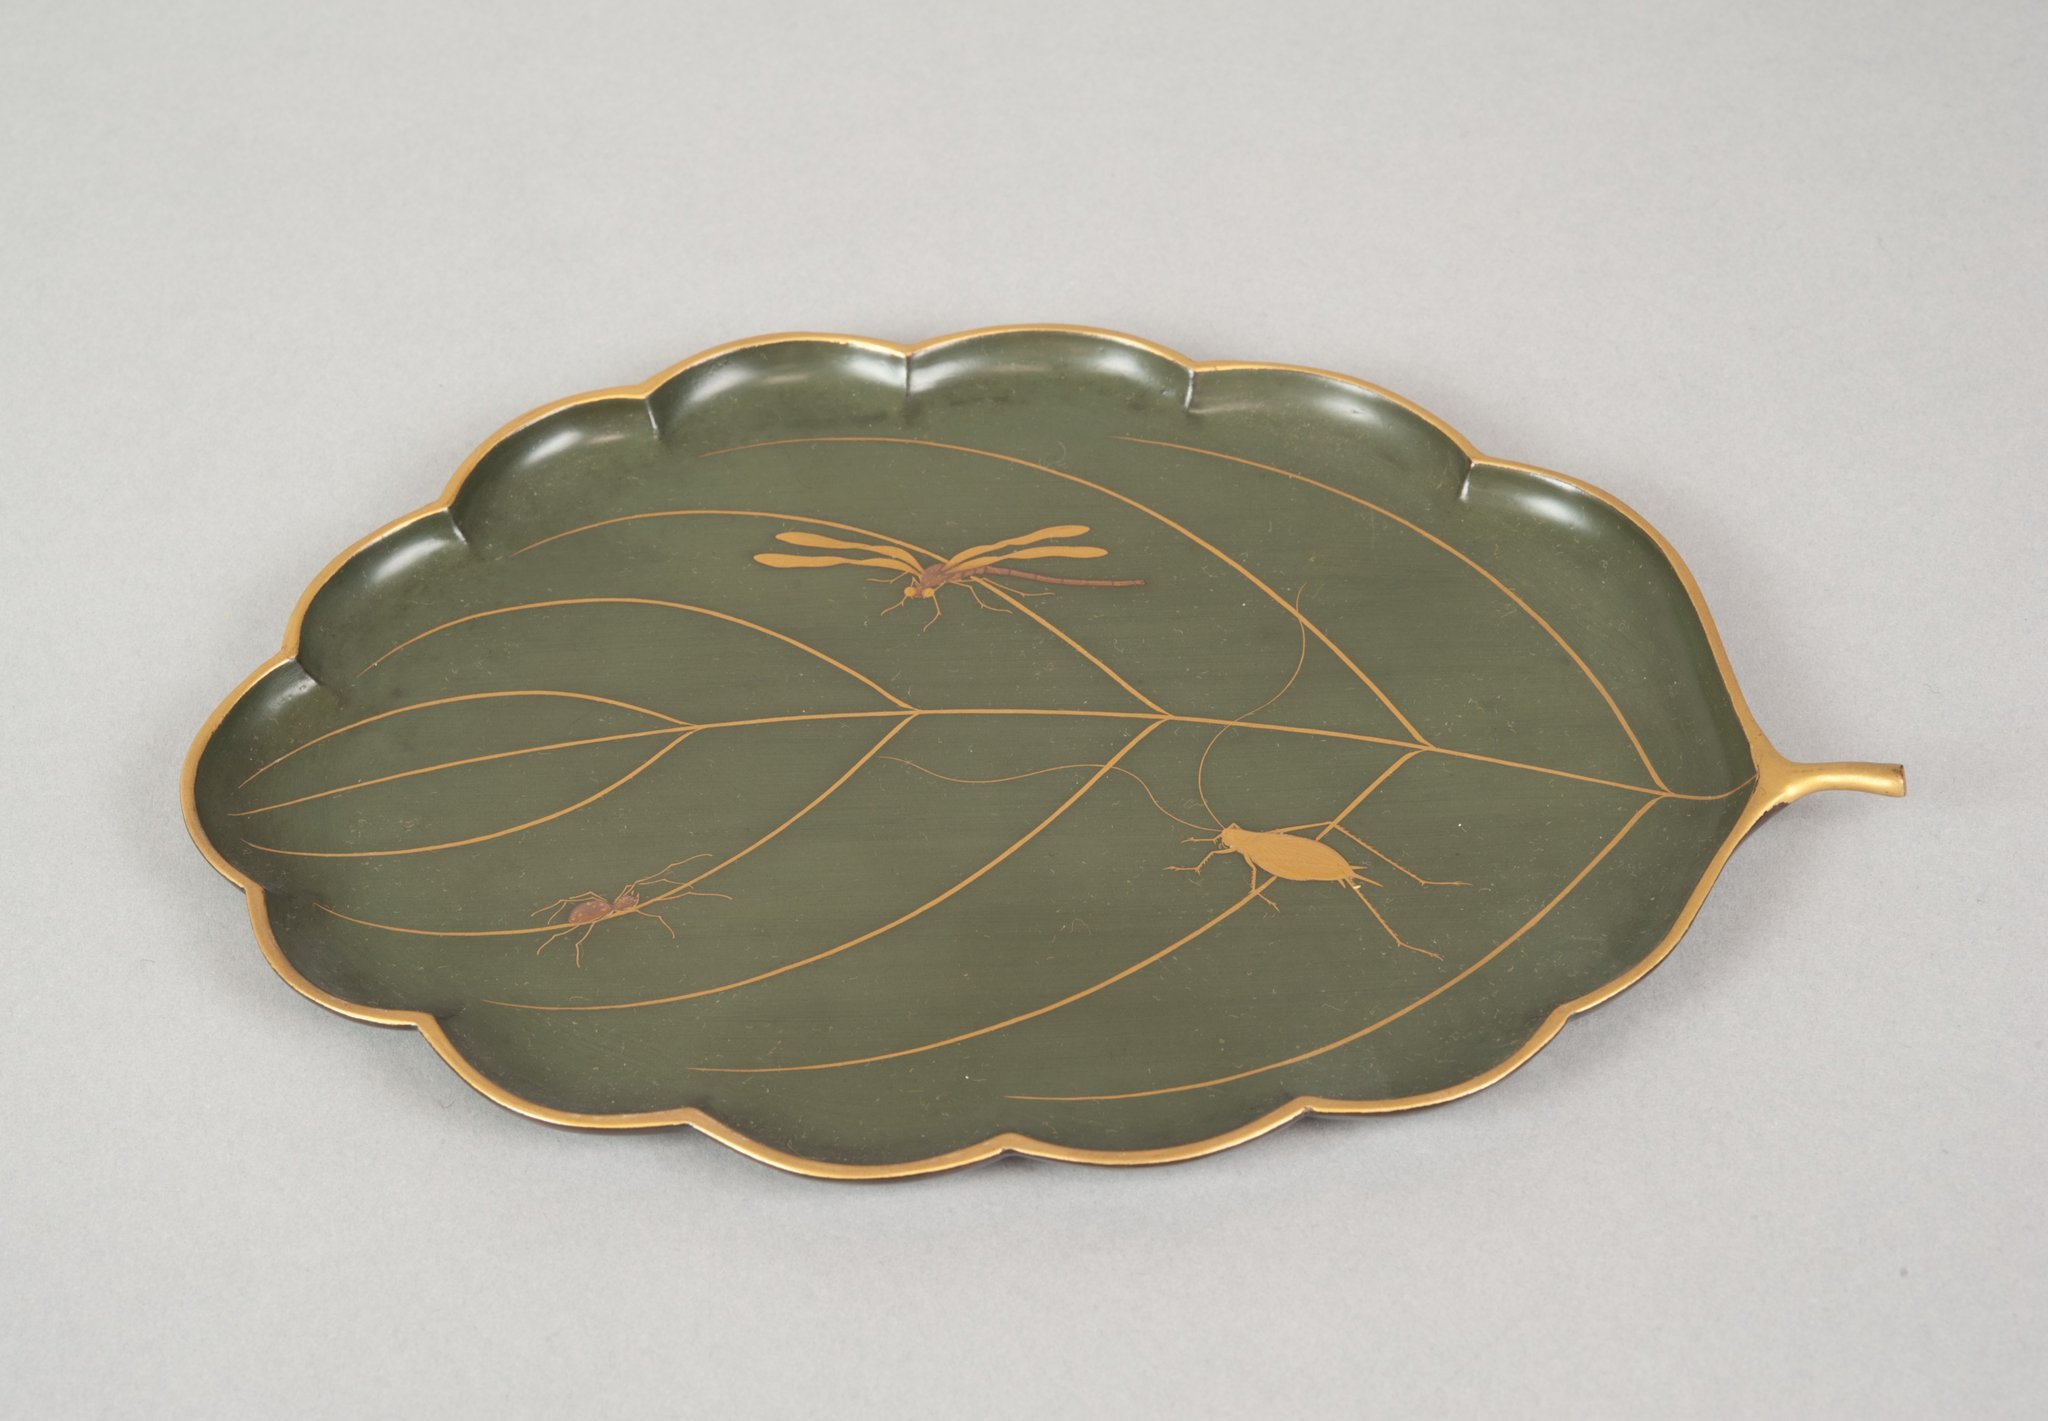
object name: tray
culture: japanese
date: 1801-1900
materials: lacquer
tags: insects